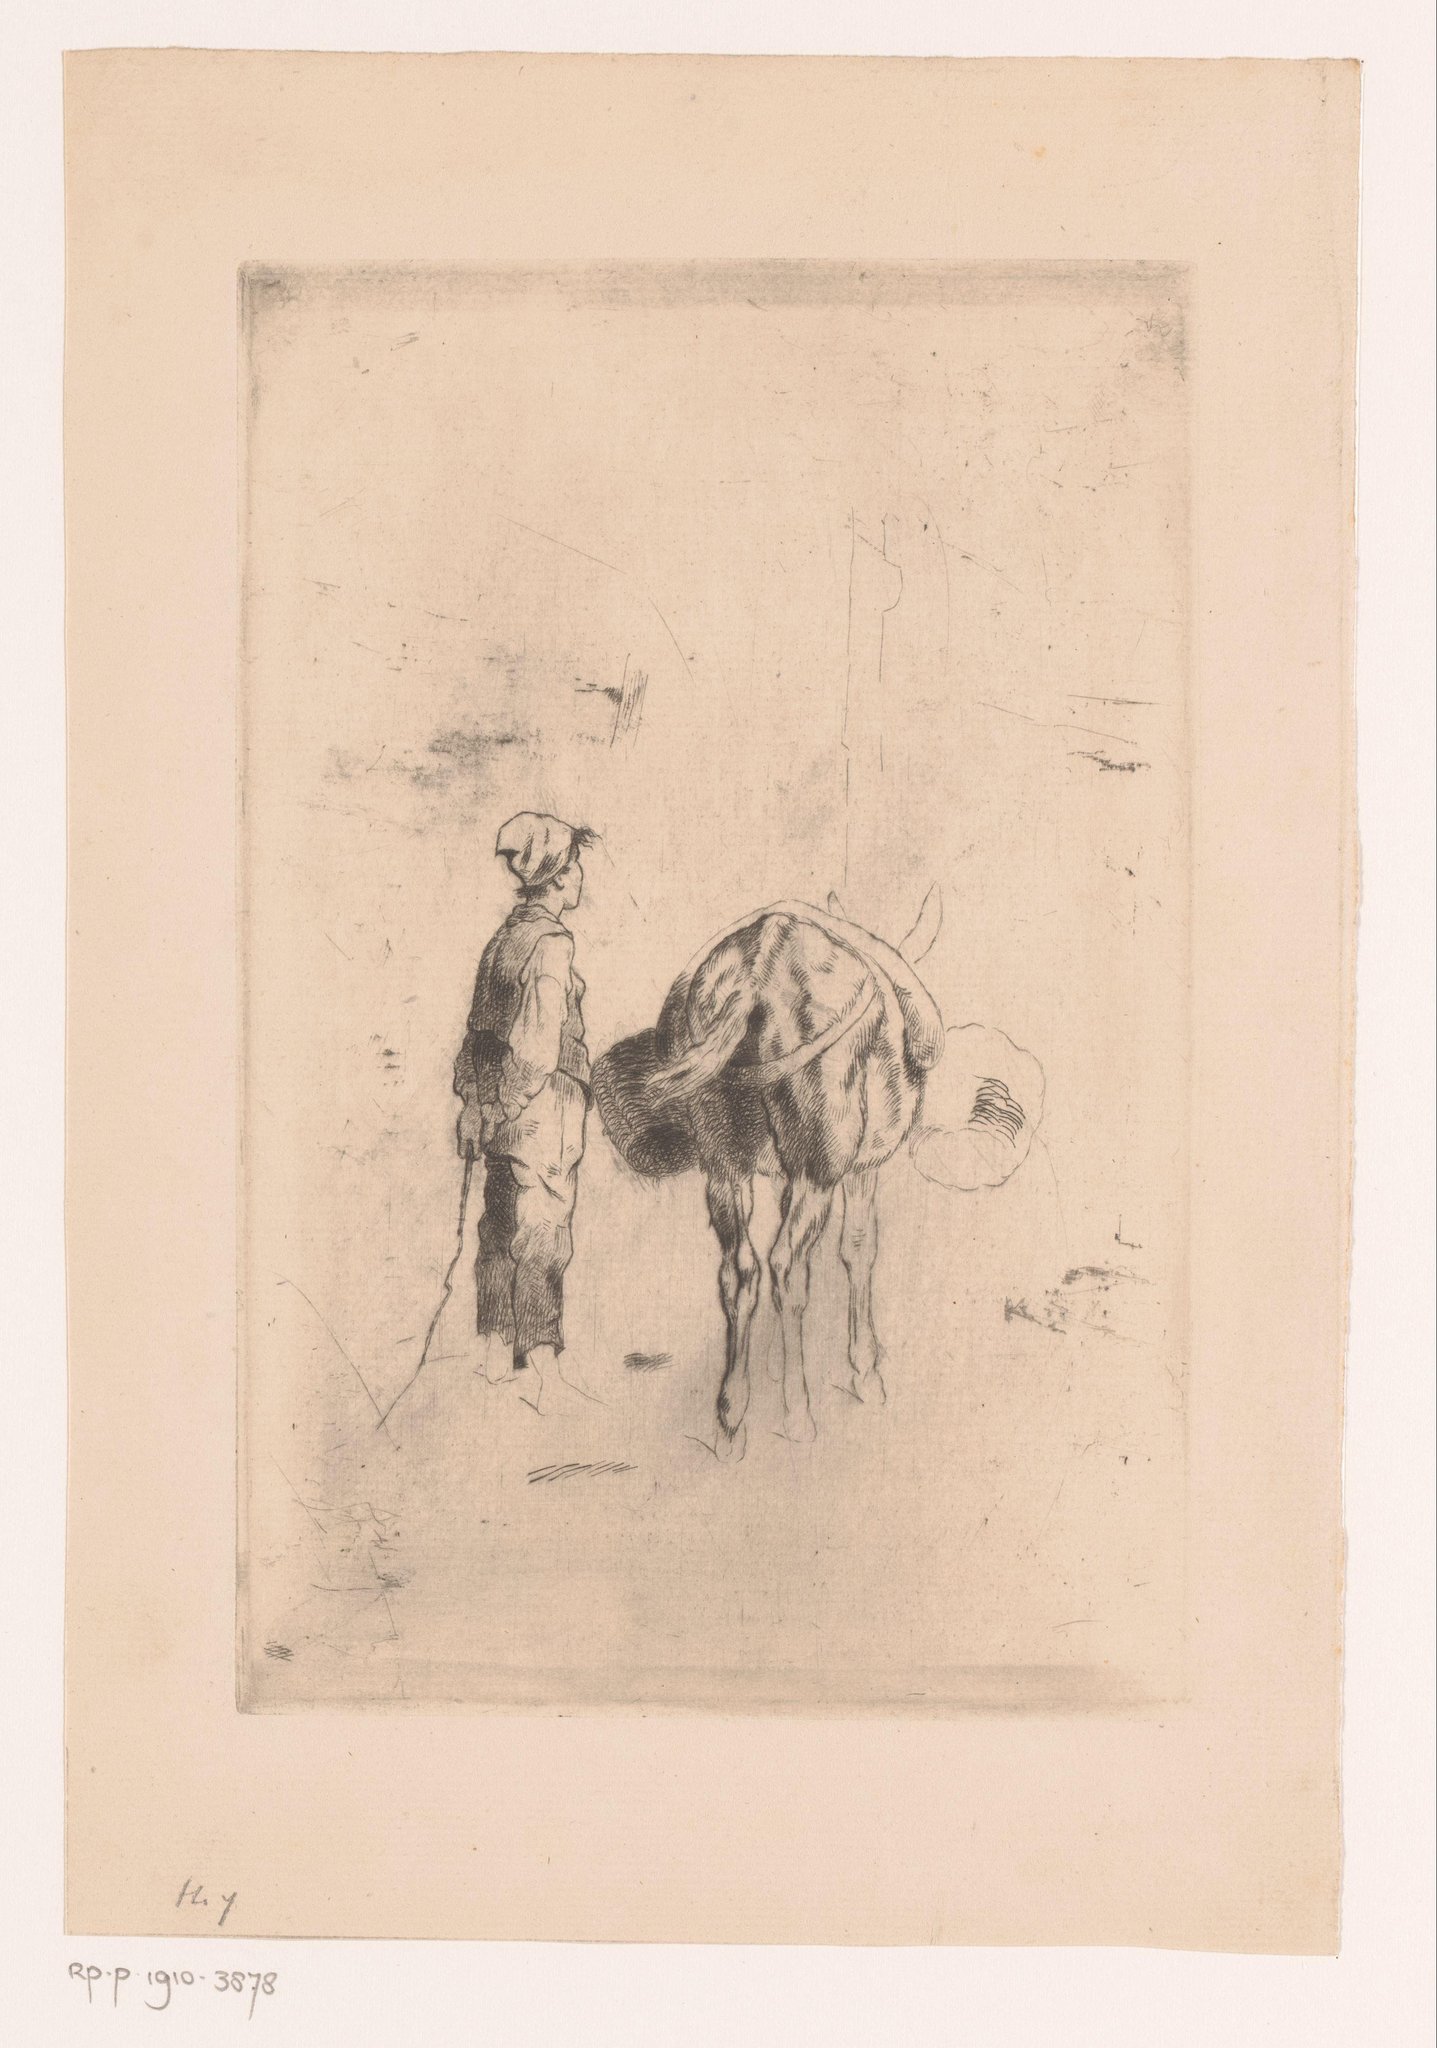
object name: print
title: Jonge ezeldrijver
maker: alfred hubert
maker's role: print maker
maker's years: 1830-1902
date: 1869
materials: paper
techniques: etching, intaglio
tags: ass, donkey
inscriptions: collector's mark: Lugt 2228